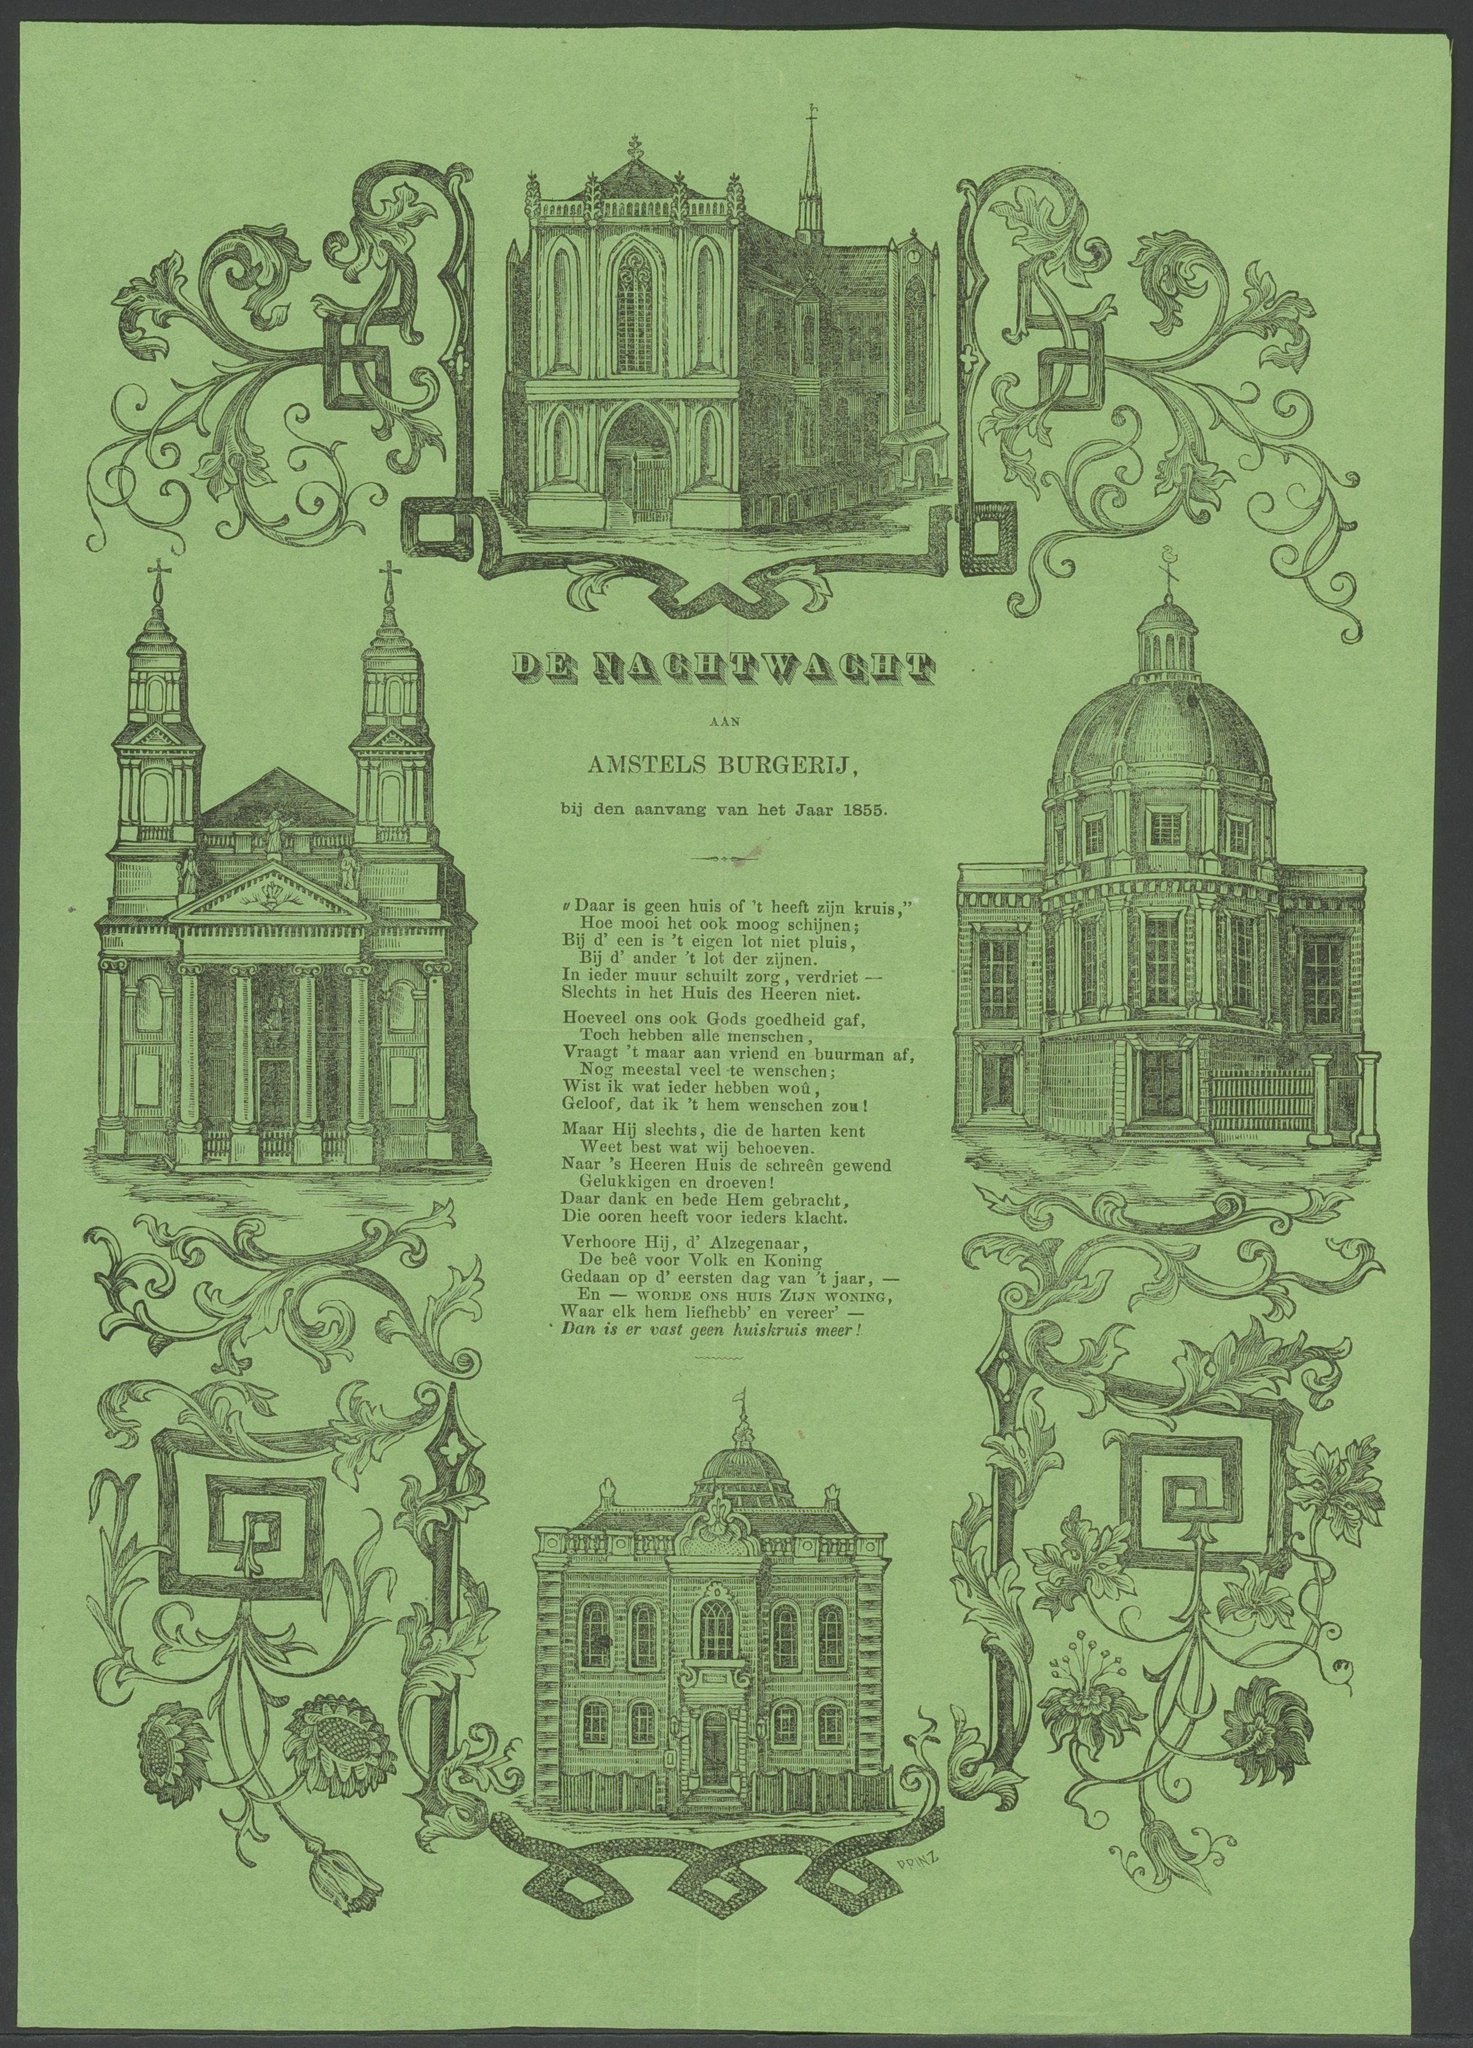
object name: print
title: De Nachtwacht aan Amstels Burgerij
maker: friedrich robert prinz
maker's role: print maker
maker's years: 1820-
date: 1854-1855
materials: paper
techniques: letterpress printing, engraving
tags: night patrol, church (exterior), amsterdam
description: Nieuwjaarswens van de Amsterdamse nachtwacht (ratelwacht) voor het jaar 1855. Centraal een gedicht in vier verzen, omringd door gebouwen tussen bladranken: de onvoltooide toren van de Nieuwe Kerk, de Mozes en Aäronkerk, de Ronde Lutherse Kerk en de Hoogduitse Synagoge. Onderwerpsrubrieken binnen de Atlas Zeden en Gewoonten: Zeden en gewoonten in engeren zin, Volksleven, Volksbladen, Nieuwjaars- en Kerstwenschen, Amsterdam.